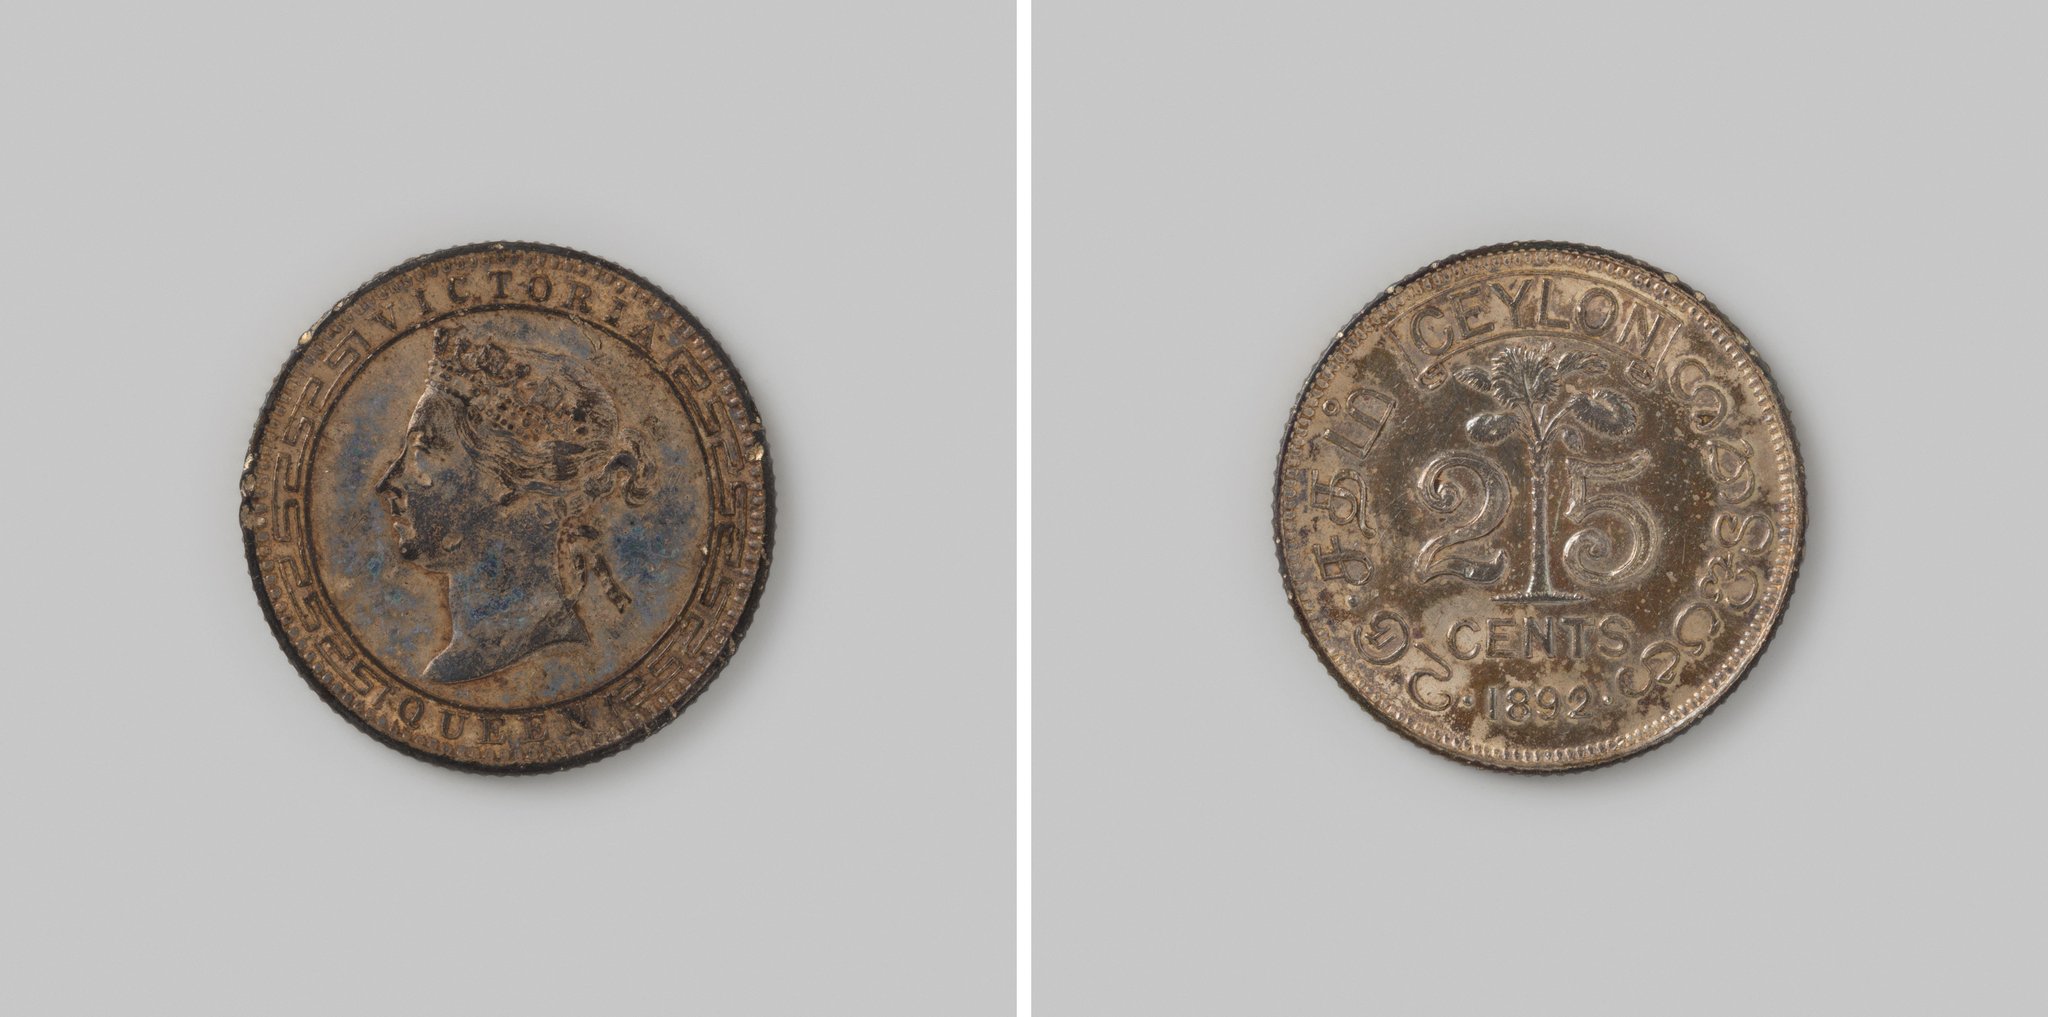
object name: coin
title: Sri Lanka, Ceylon, 25 cents op naam van koningin Victoria,1892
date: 1892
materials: silver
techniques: striking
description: Zilveren munt. Voorzijde: hoofd met diadeem van de koningin naar links. Keerzijde: tussen waarde-aanduiding - in twee regels - palmboom. Jaartal onderaan. Kartelrand.